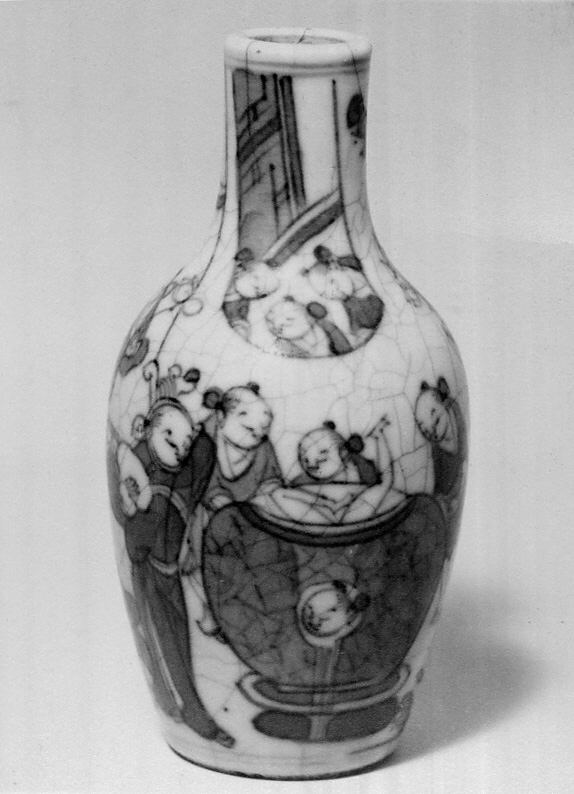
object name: snuff bottle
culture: chinese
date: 1736-1795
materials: paste, porcelain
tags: human figures